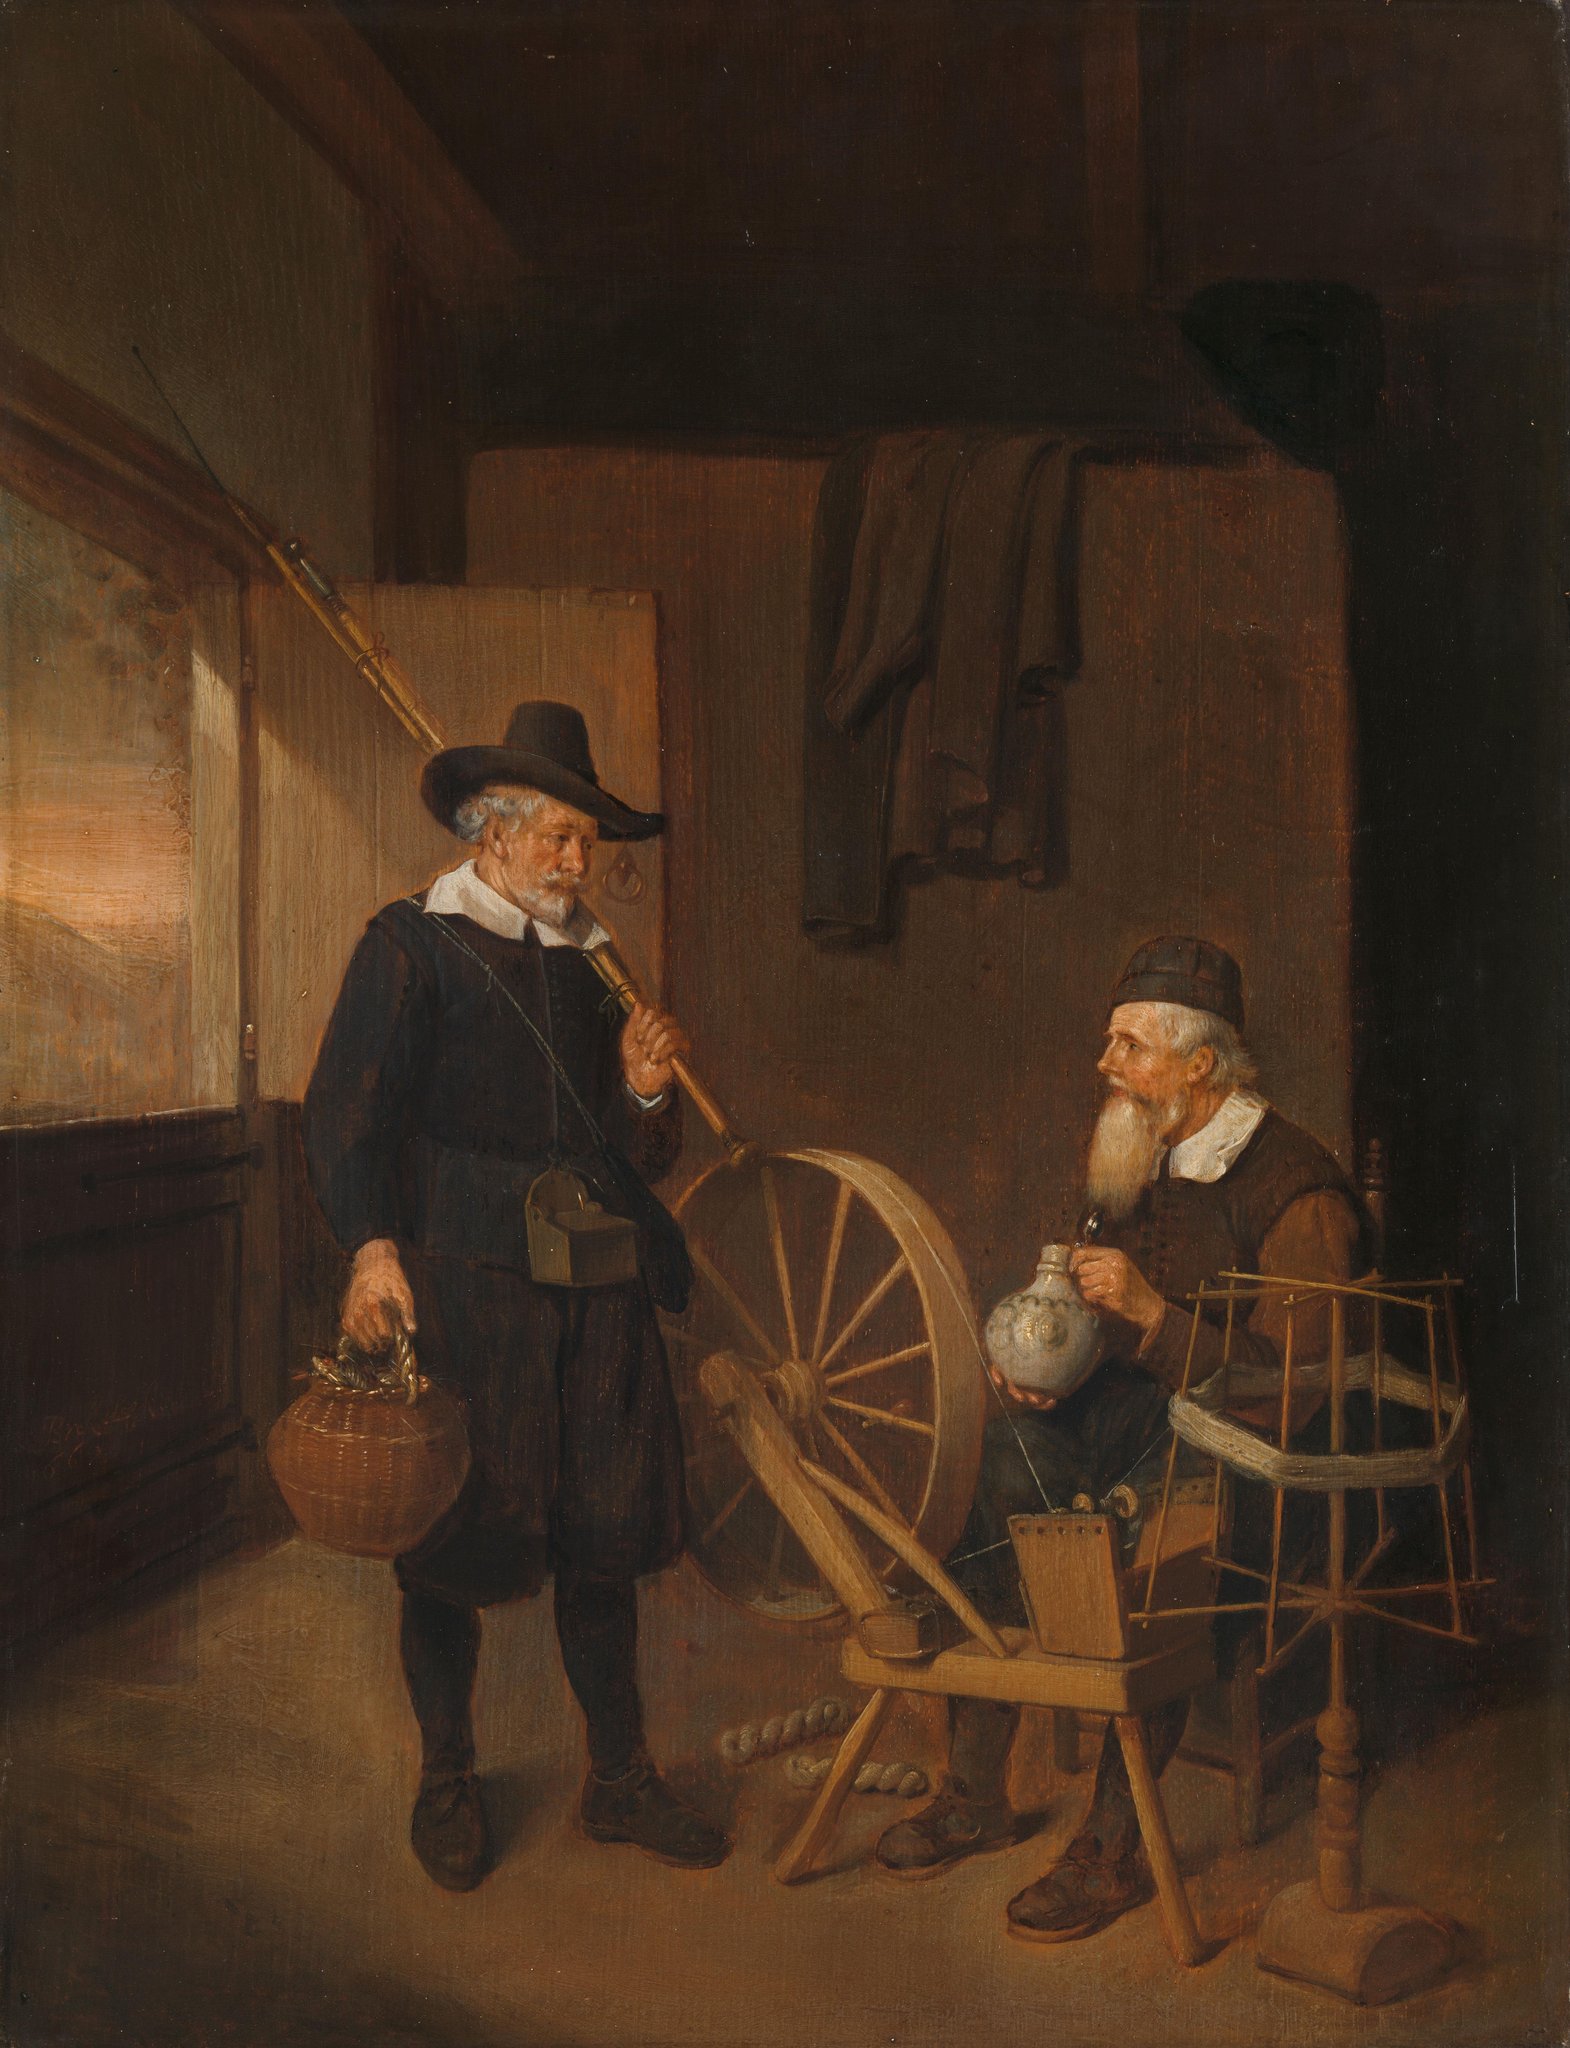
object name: painting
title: Interior with Fisherman and Man beside a Bobbin and Spool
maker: quiringh gerritsz. van brekelenkam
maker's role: draughtsman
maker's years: 1622-1669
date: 1663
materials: oil, panel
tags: spinning-wheel, angling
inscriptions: signature and date: ‘Brekelenkam 1663’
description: Interieur met hengelaar en man bij spoelrad en haspel. Beiden zijn oude mannen met witte baarden. De visser maakt een praatje met de spinner die net een slok uit een stenen kruik heeft genomen. Op de grond liggen twee knotten wol.